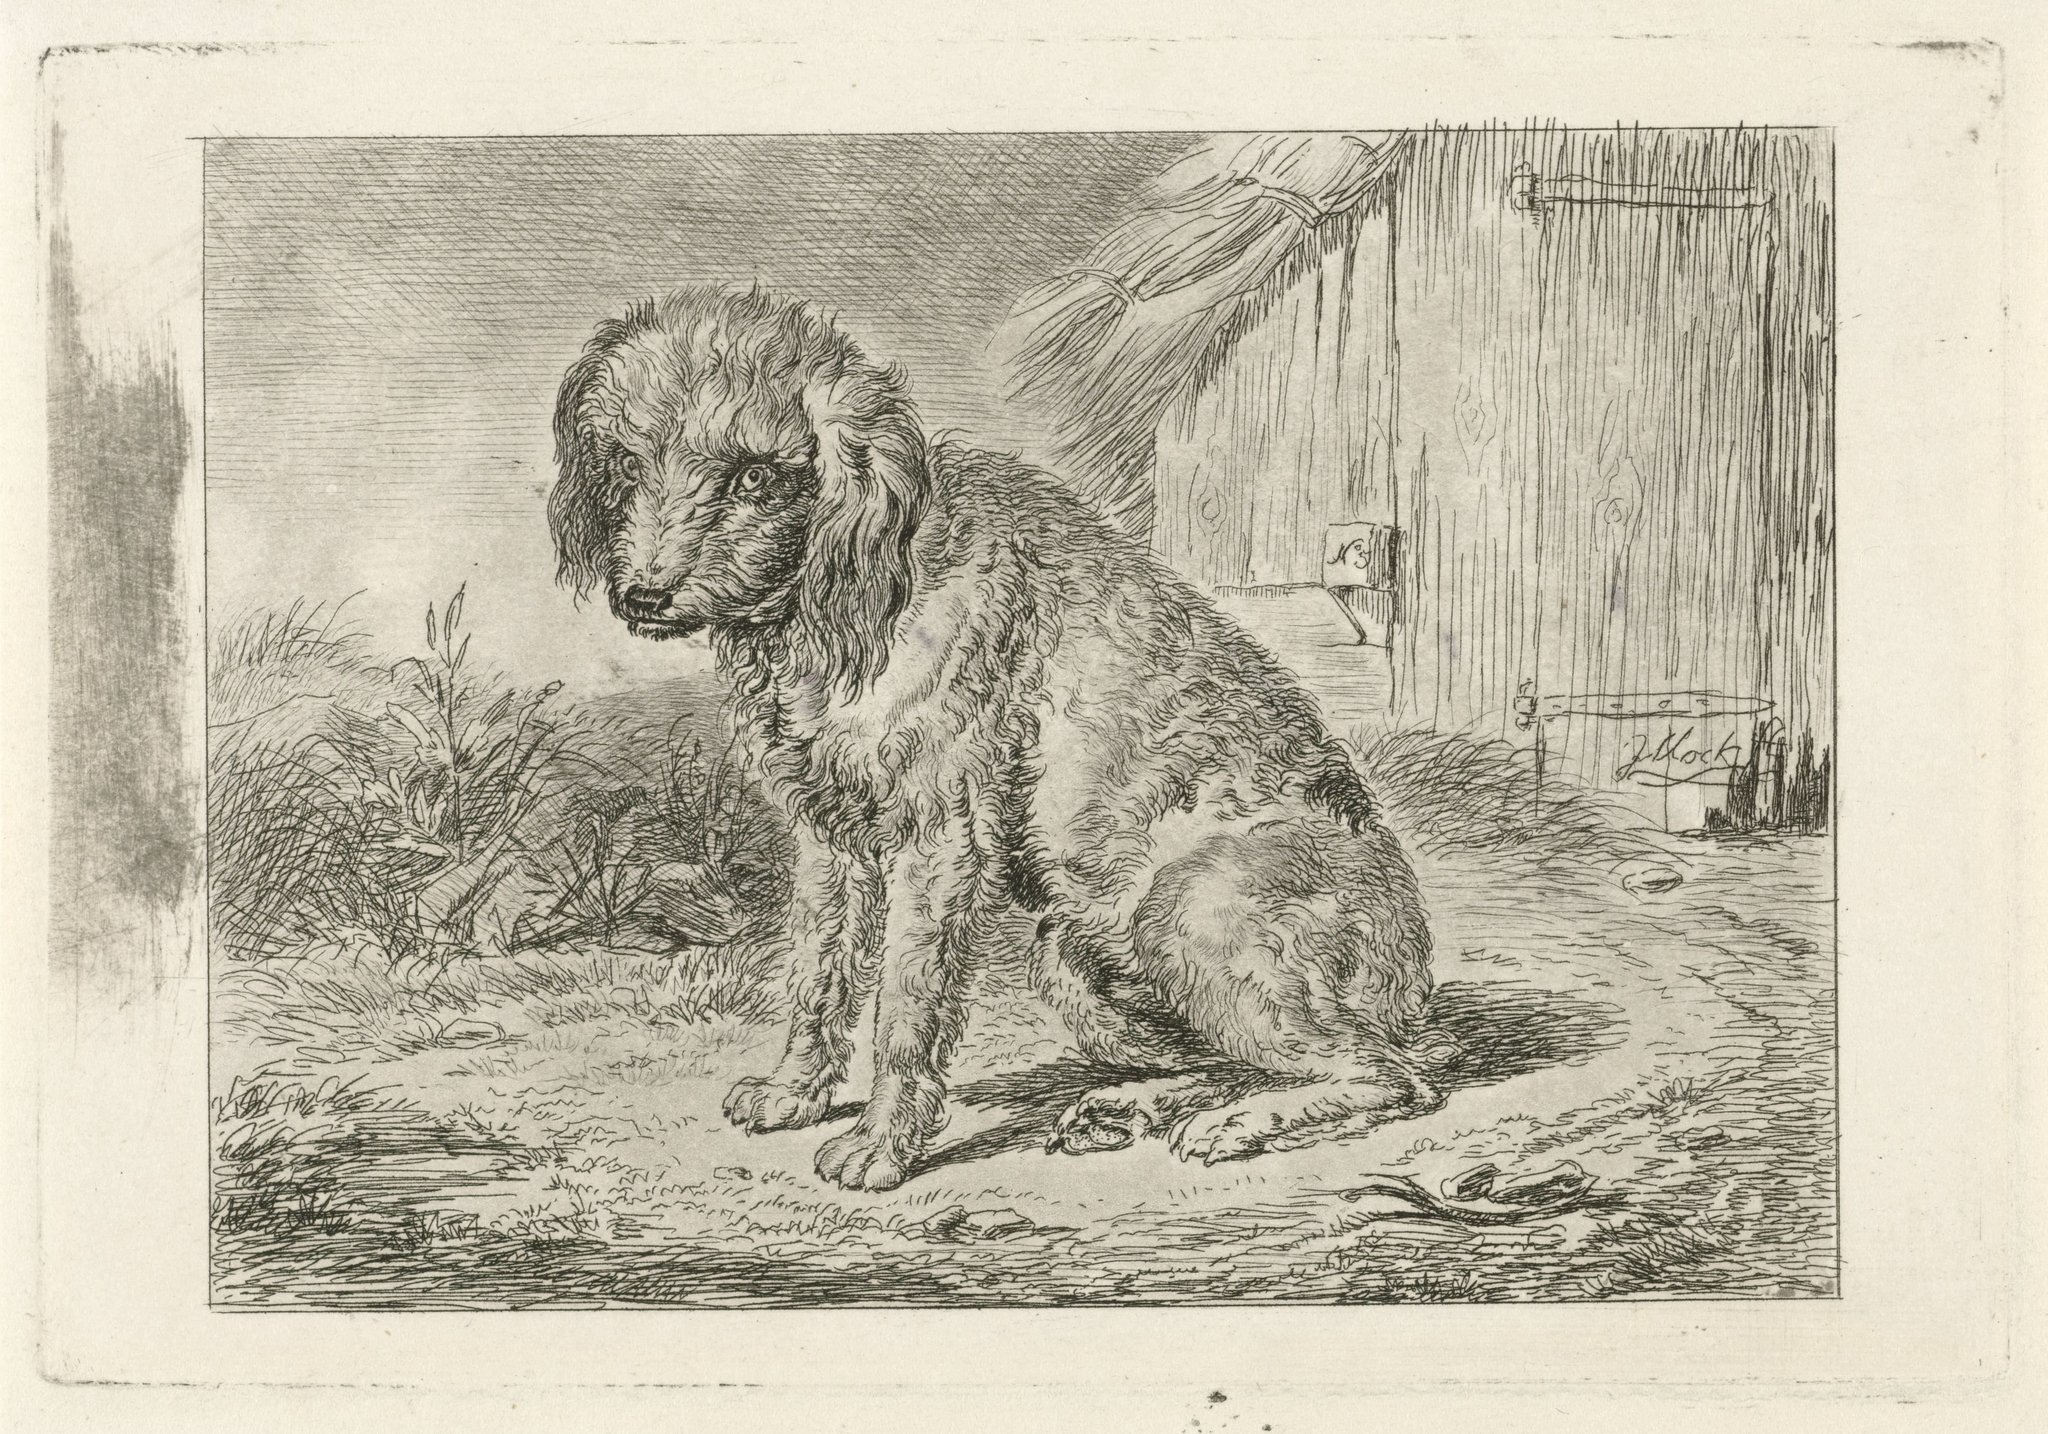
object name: print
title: Zittende hond bij een schuur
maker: johannes mock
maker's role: draughtsman, painter, print maker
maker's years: 1800-1884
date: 1810-1884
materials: paper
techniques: etching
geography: netherlands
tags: dog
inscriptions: collector's mark: Lugt 2228